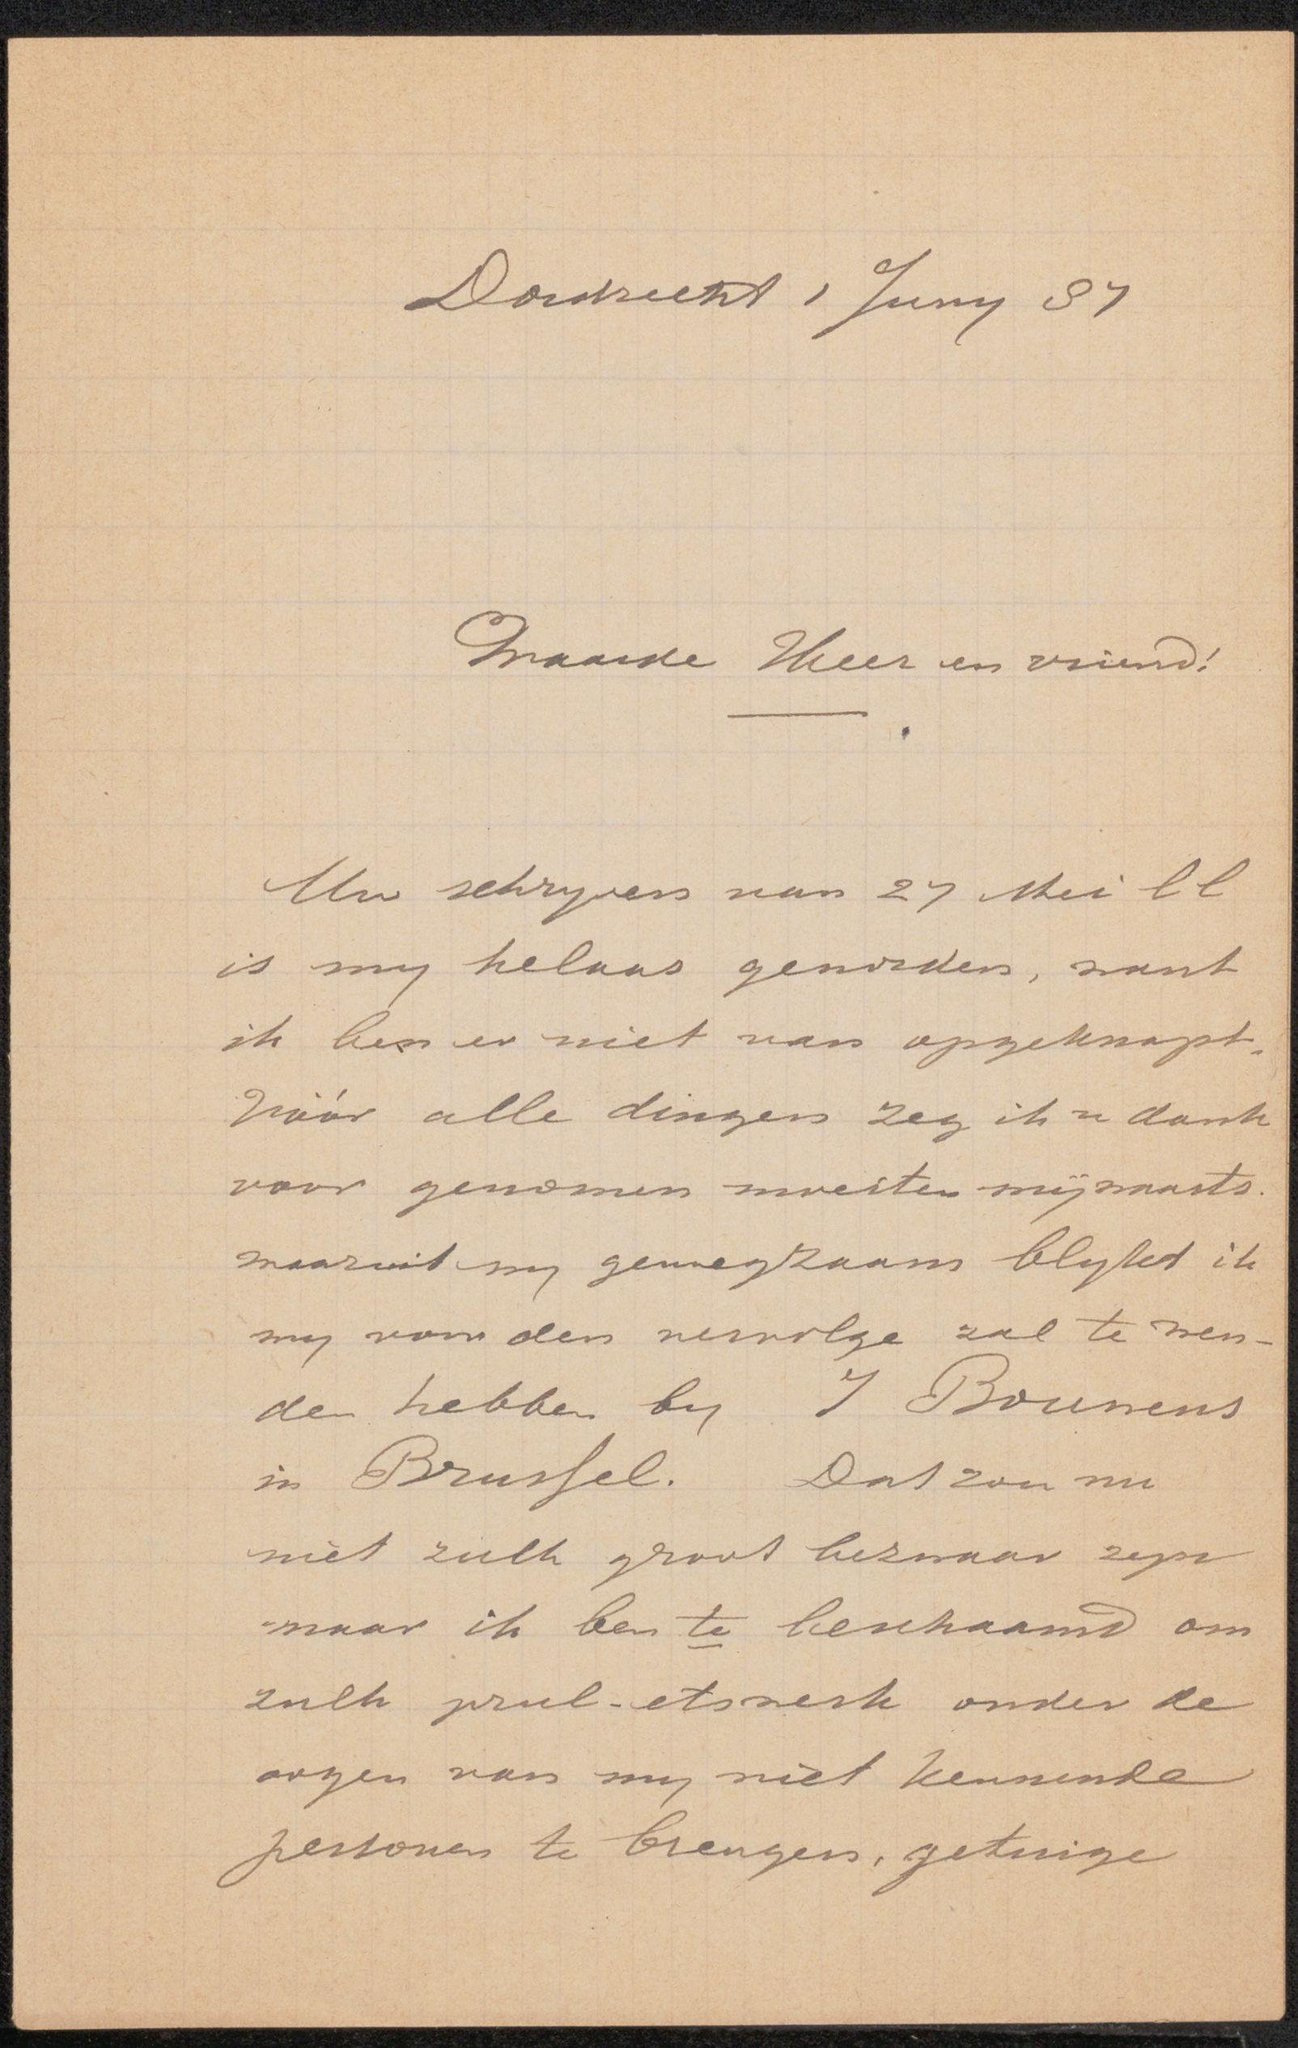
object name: letter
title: Brief aan Jan Veth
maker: frans lebret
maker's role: draughtsman, painter, print maker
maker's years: 1820-1909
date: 1887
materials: ink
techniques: pen, writing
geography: dordrecht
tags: designer, jan veth, printer, joseph bouwens, the graphic arts, brussels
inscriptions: collector's mark: ‘RPK’